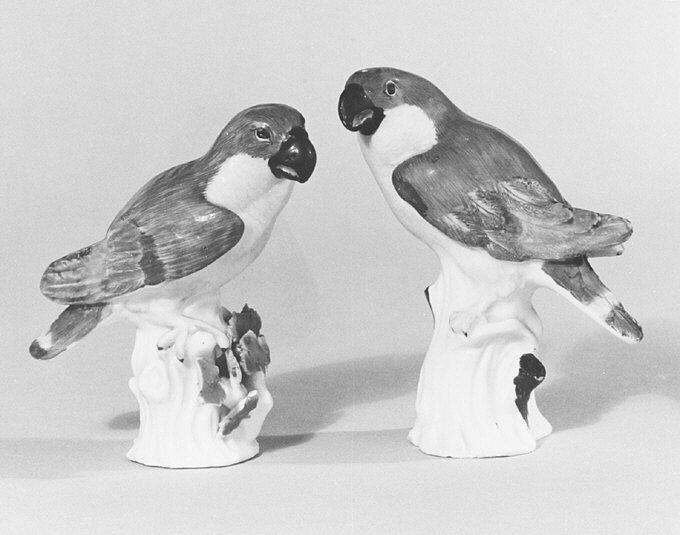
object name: figure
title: Parrot (one of a pair)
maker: meissen manufactory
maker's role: manufactory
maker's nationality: german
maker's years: 1710-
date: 1741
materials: hard paste porcelain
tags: parrots